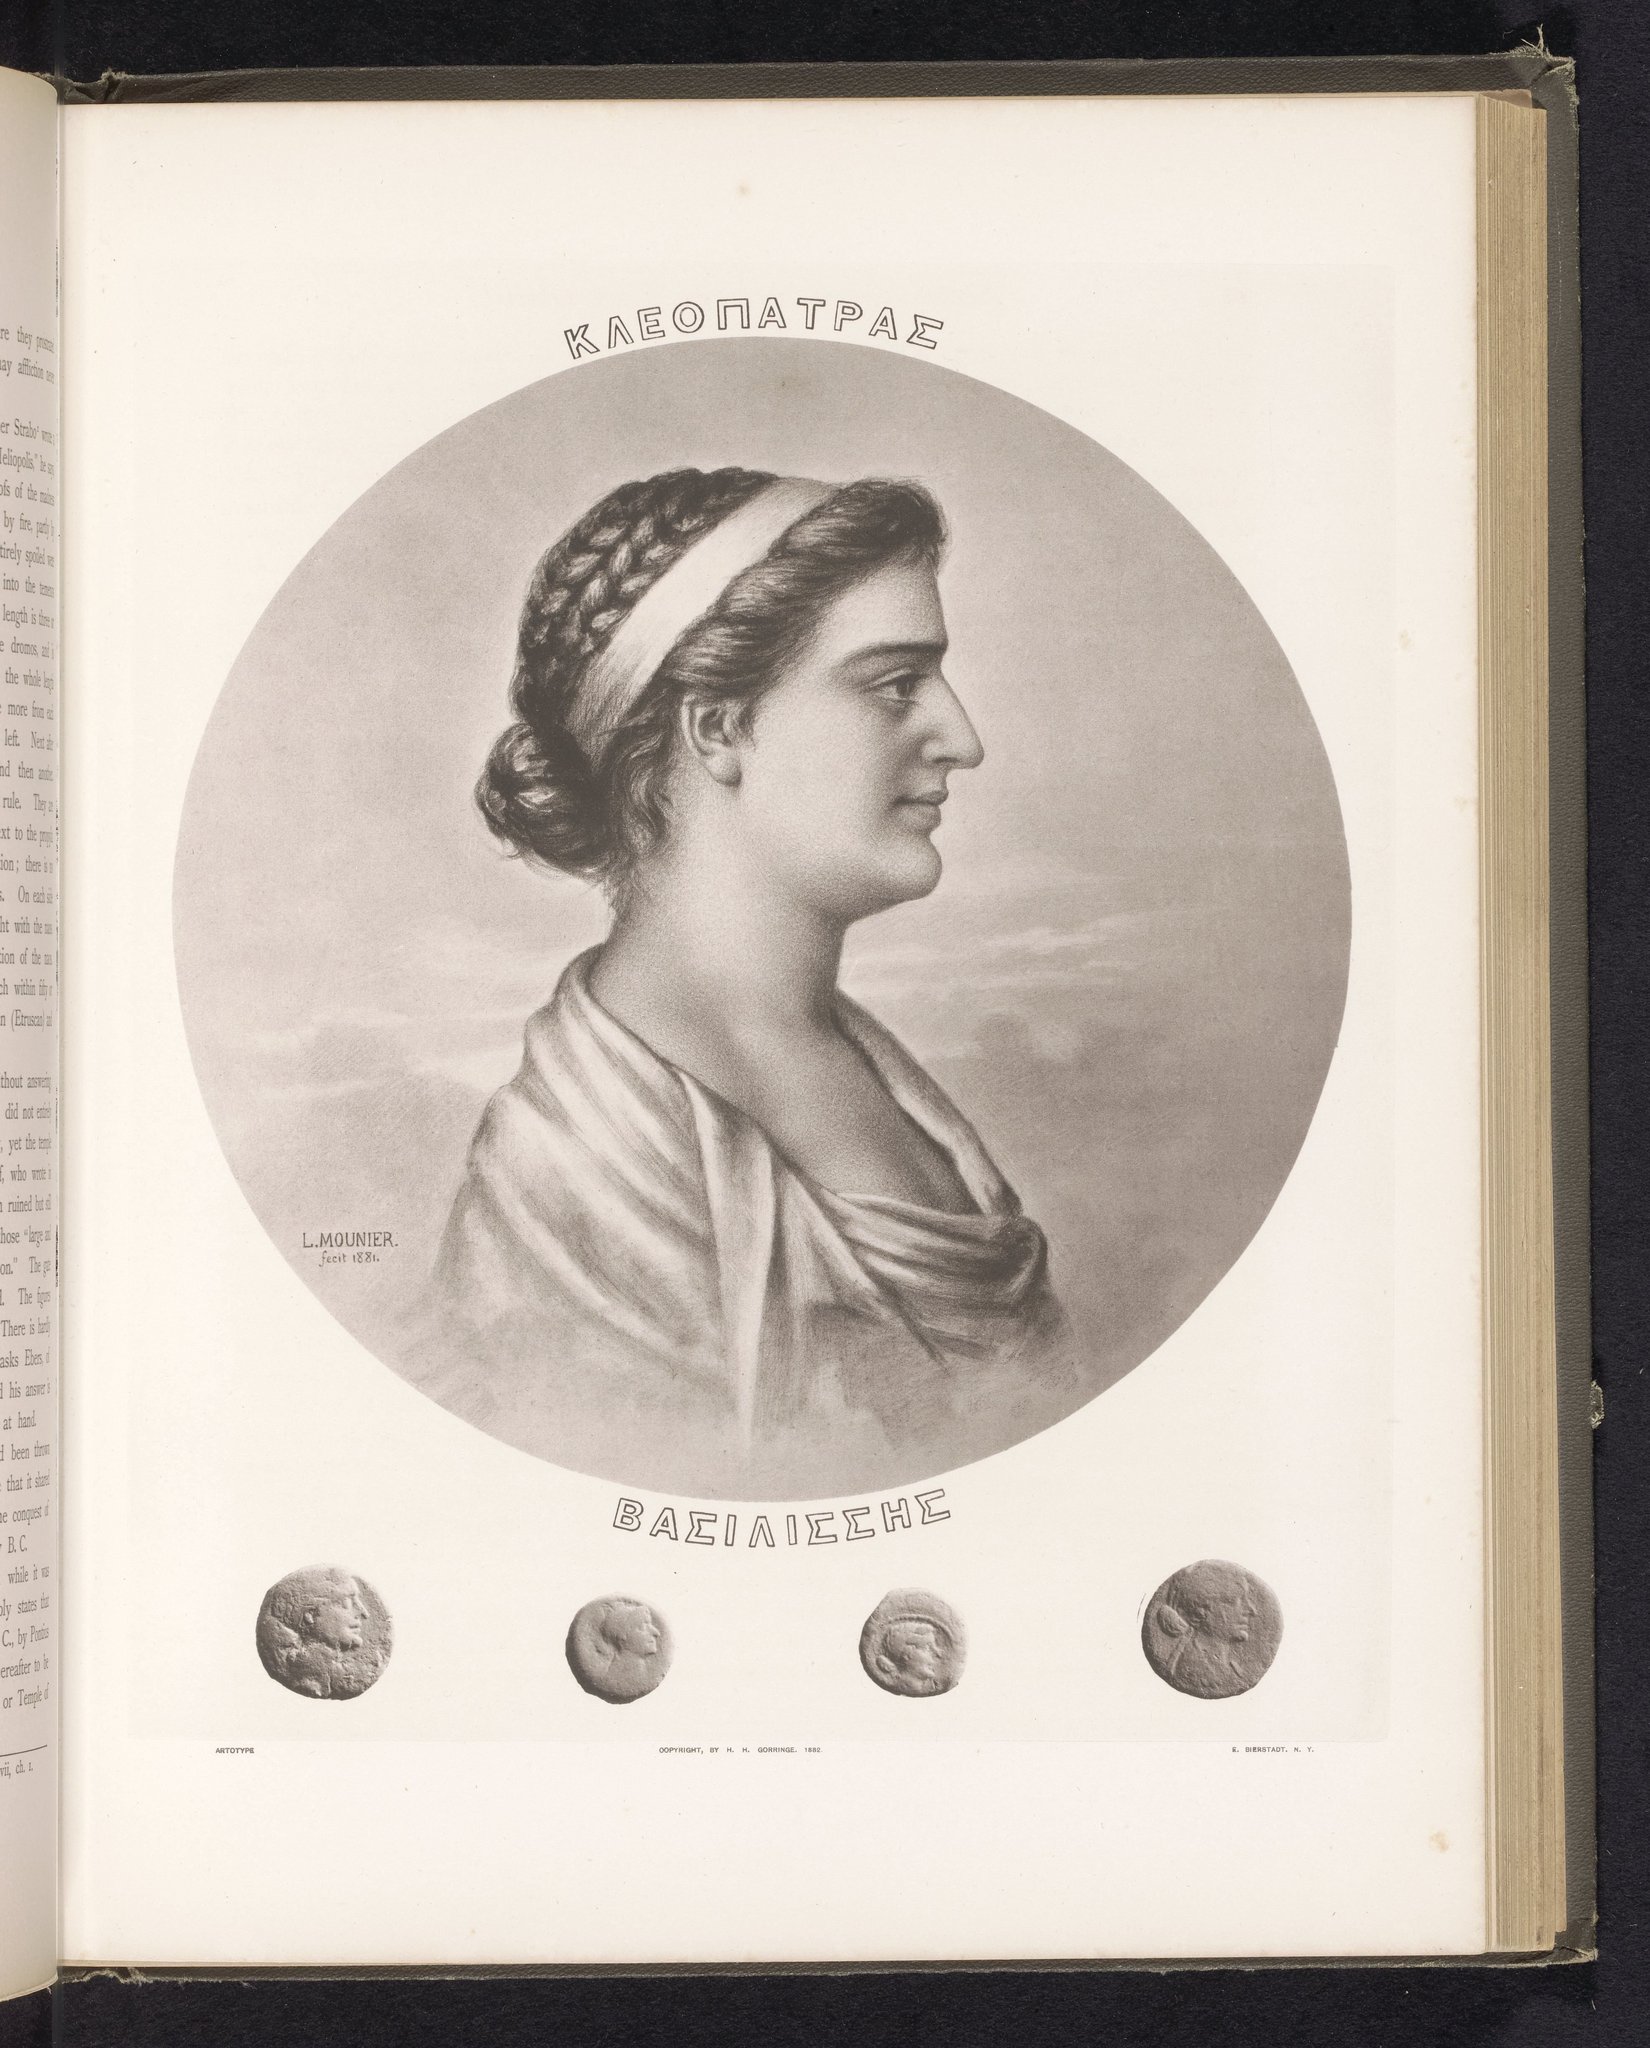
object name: photomechanical print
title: Fotoreproductie van een tekening, voorstellende een fictief portret van Cleopatra VII, en vier portretten van Cleopatra VII op munten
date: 1882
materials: paper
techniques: photograph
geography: new york city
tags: (story of) cleopatra, ruler, sovereign - bb - female ruler, coin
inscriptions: inscription: ‘Copyright, by H.H. Gorringe, 1882’